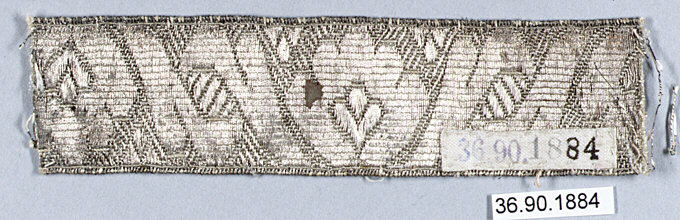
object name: galloon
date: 1801-1900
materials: metal thread, silk